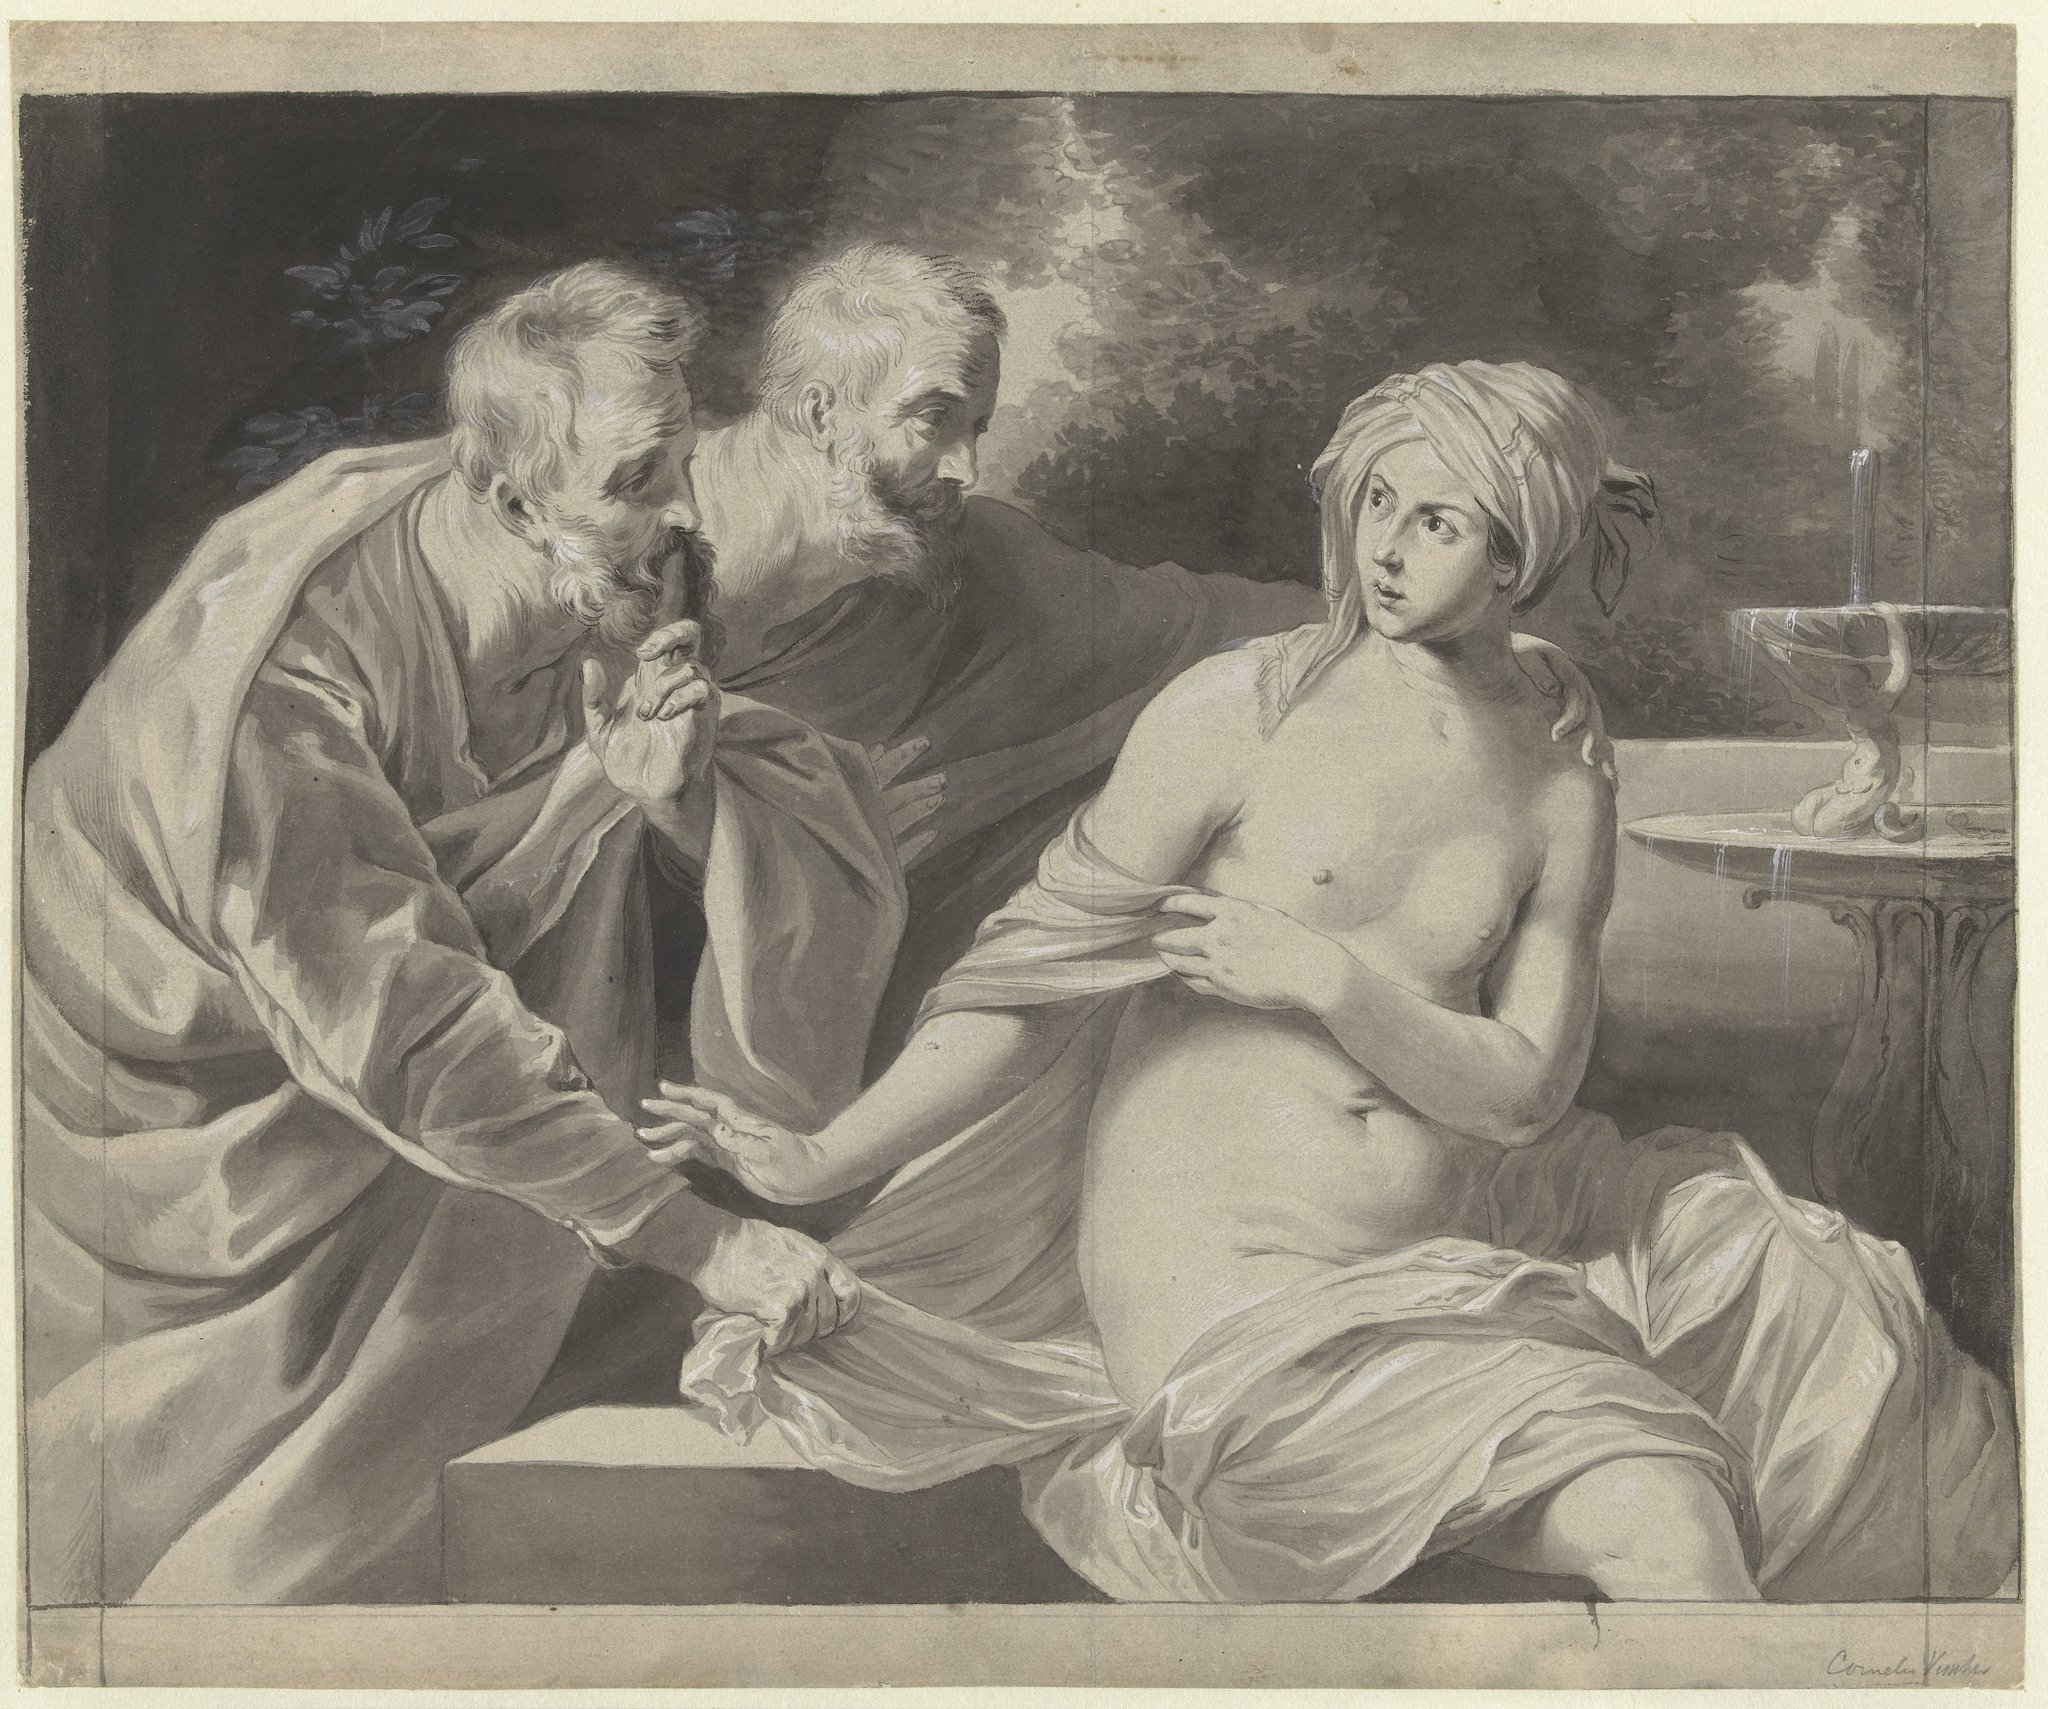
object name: drawing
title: Susanna and the Elders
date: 1654-1658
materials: paint, paper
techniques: brush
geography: amsterdam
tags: the elders making advances towards susanna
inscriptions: : Lugt 240